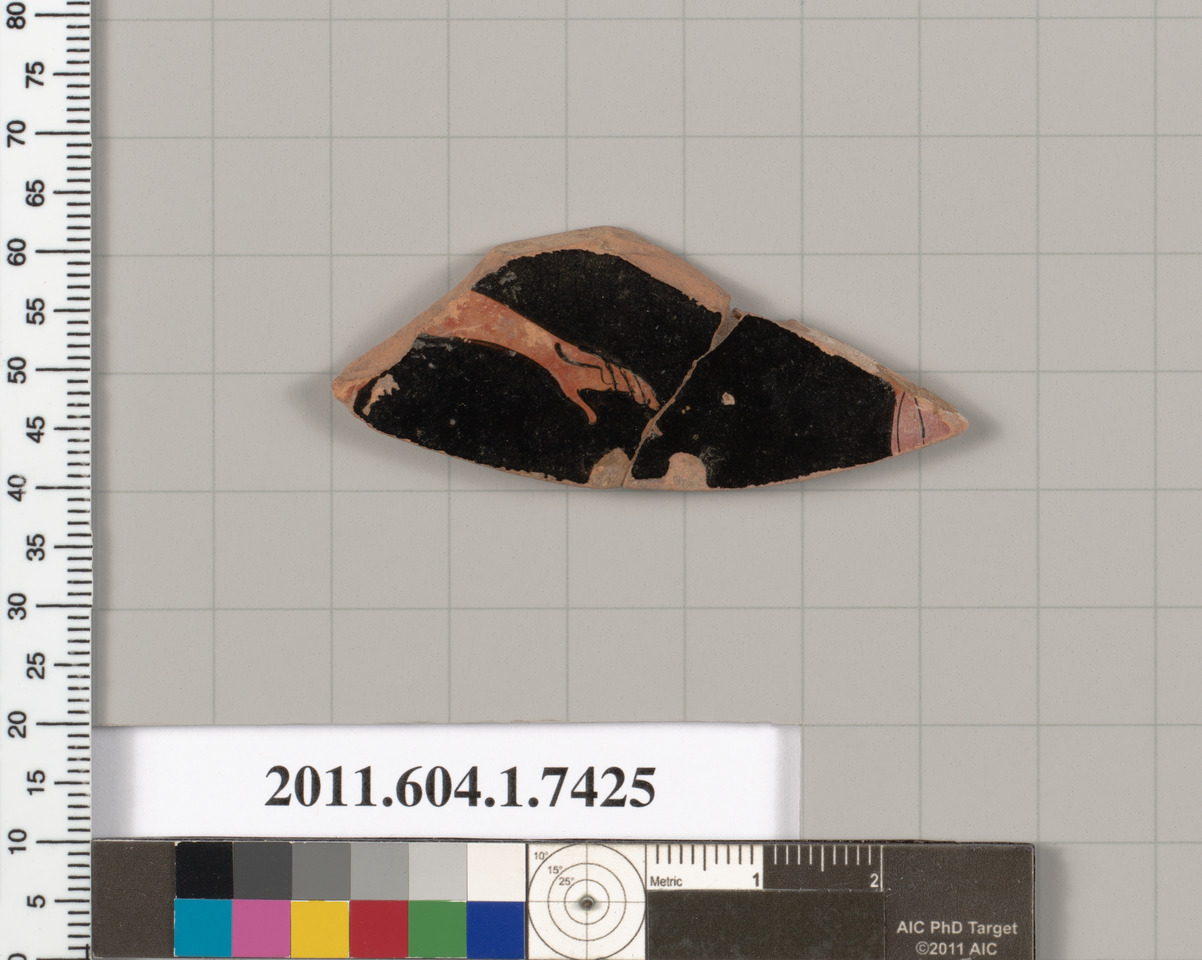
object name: kylix fragment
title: Terracotta fragment of a kylix (drinking cup)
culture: greek, attic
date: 490-470 BCE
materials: terracotta